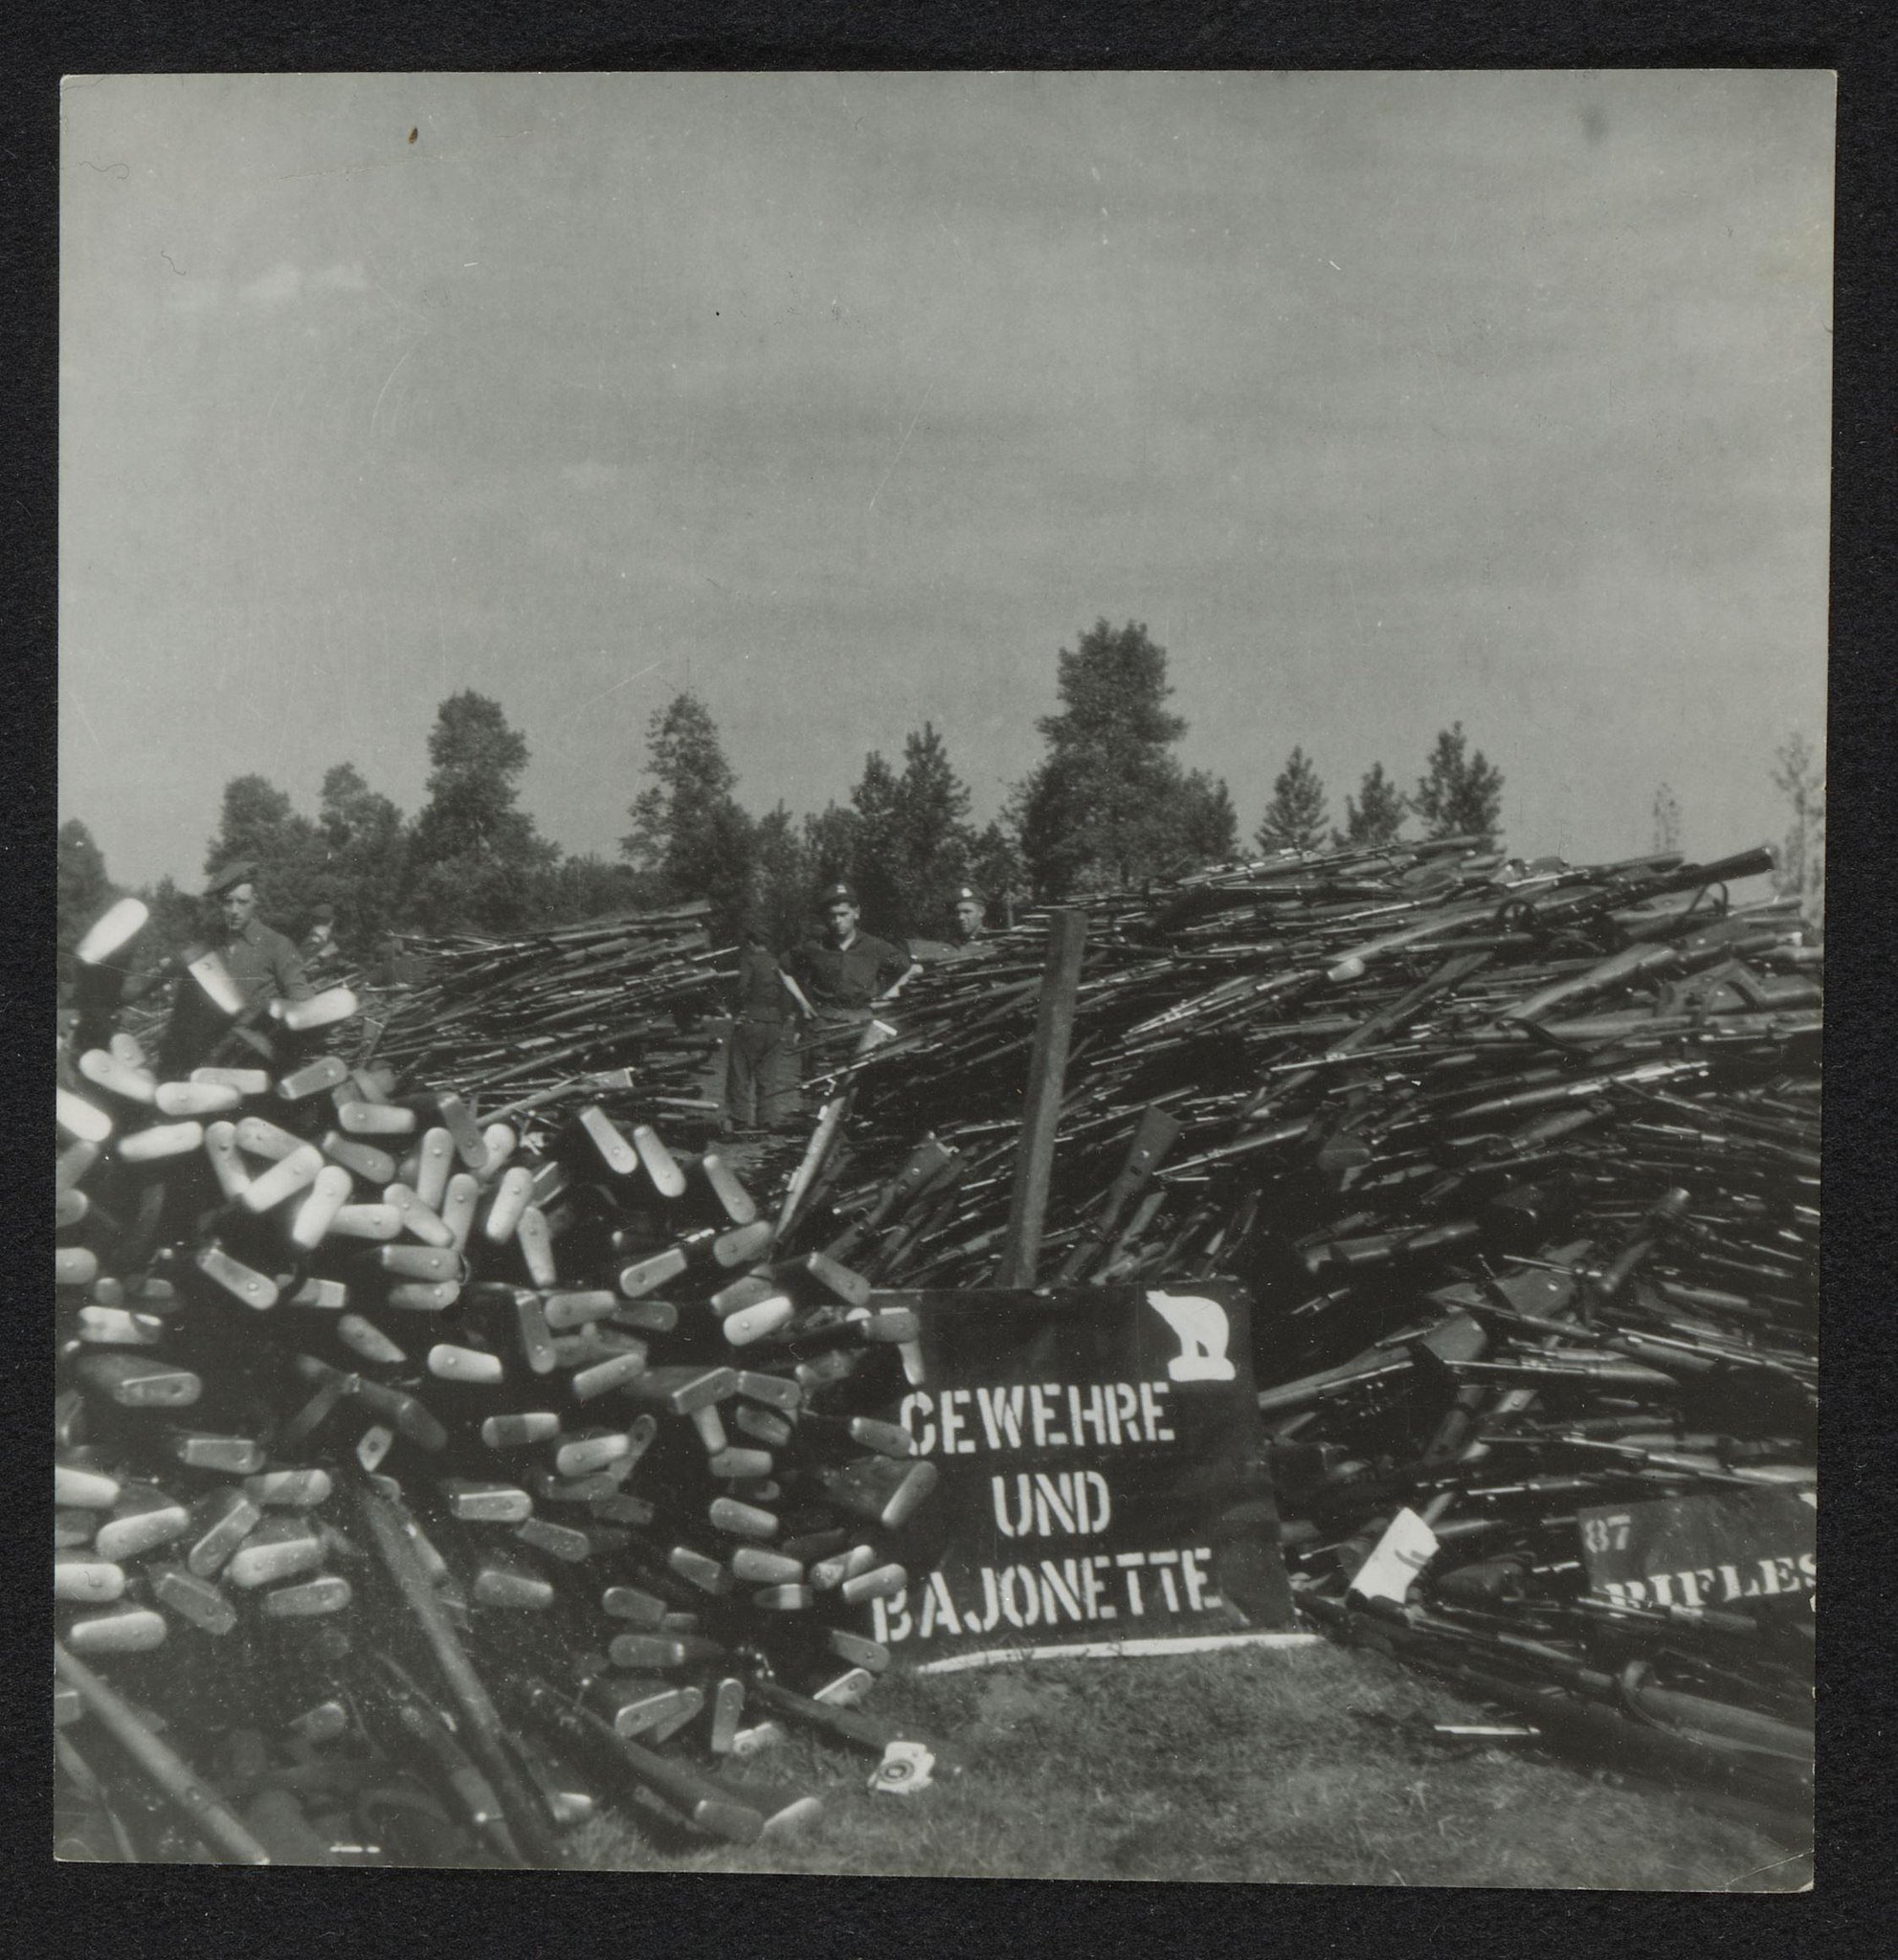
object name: photograph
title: Het verzamelkamp te Soest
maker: willem van de poll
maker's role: fotograaf, journalist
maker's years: 1895-1970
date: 1905-1945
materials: photographic support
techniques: gelatin silver print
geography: netherlands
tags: soest (utrecht), bevrijding tweede wereldoorlog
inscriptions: label: ‘10 Mei 1940: De dag ... WILLEM VAN DE POLL)’, copyright notice: ‘Copyright ANEFO No. 3047’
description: Verzamelkamp te Soest waar de Duitse troepen tijdens de terugtocht hun wapens in moesten leveren, mei 1945. Enkele militairen houden wacht bij grote stapels geweren.